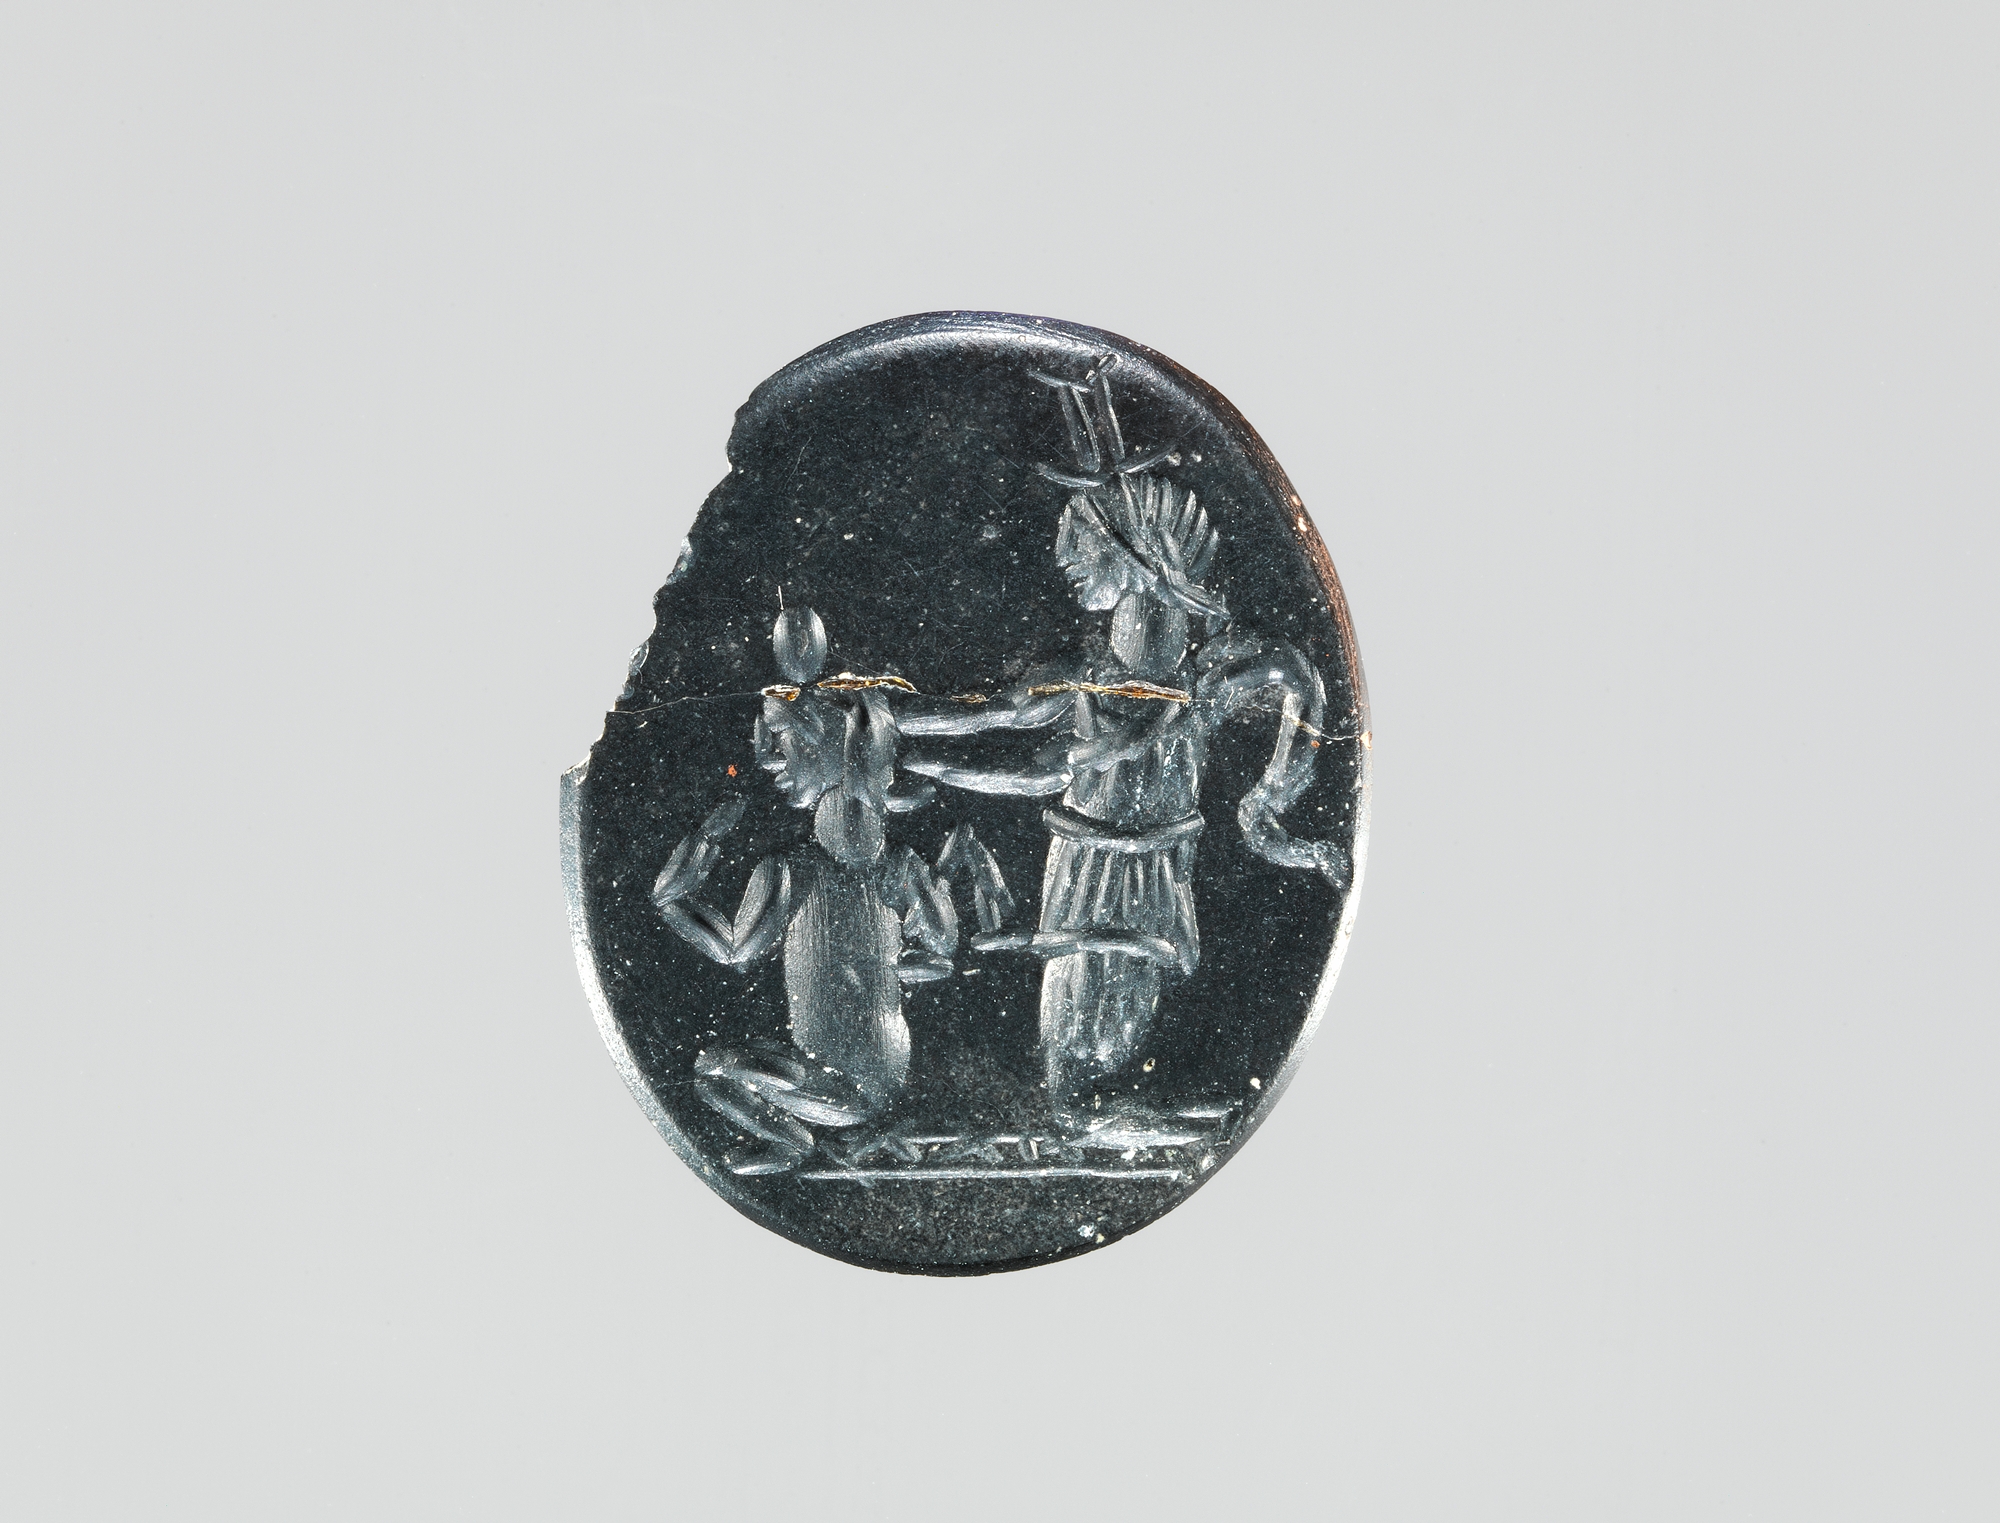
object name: intaglio, magical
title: Hematite intaglio: Isis and Harpocrates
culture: roman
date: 201-300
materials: mineral, jasper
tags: isis